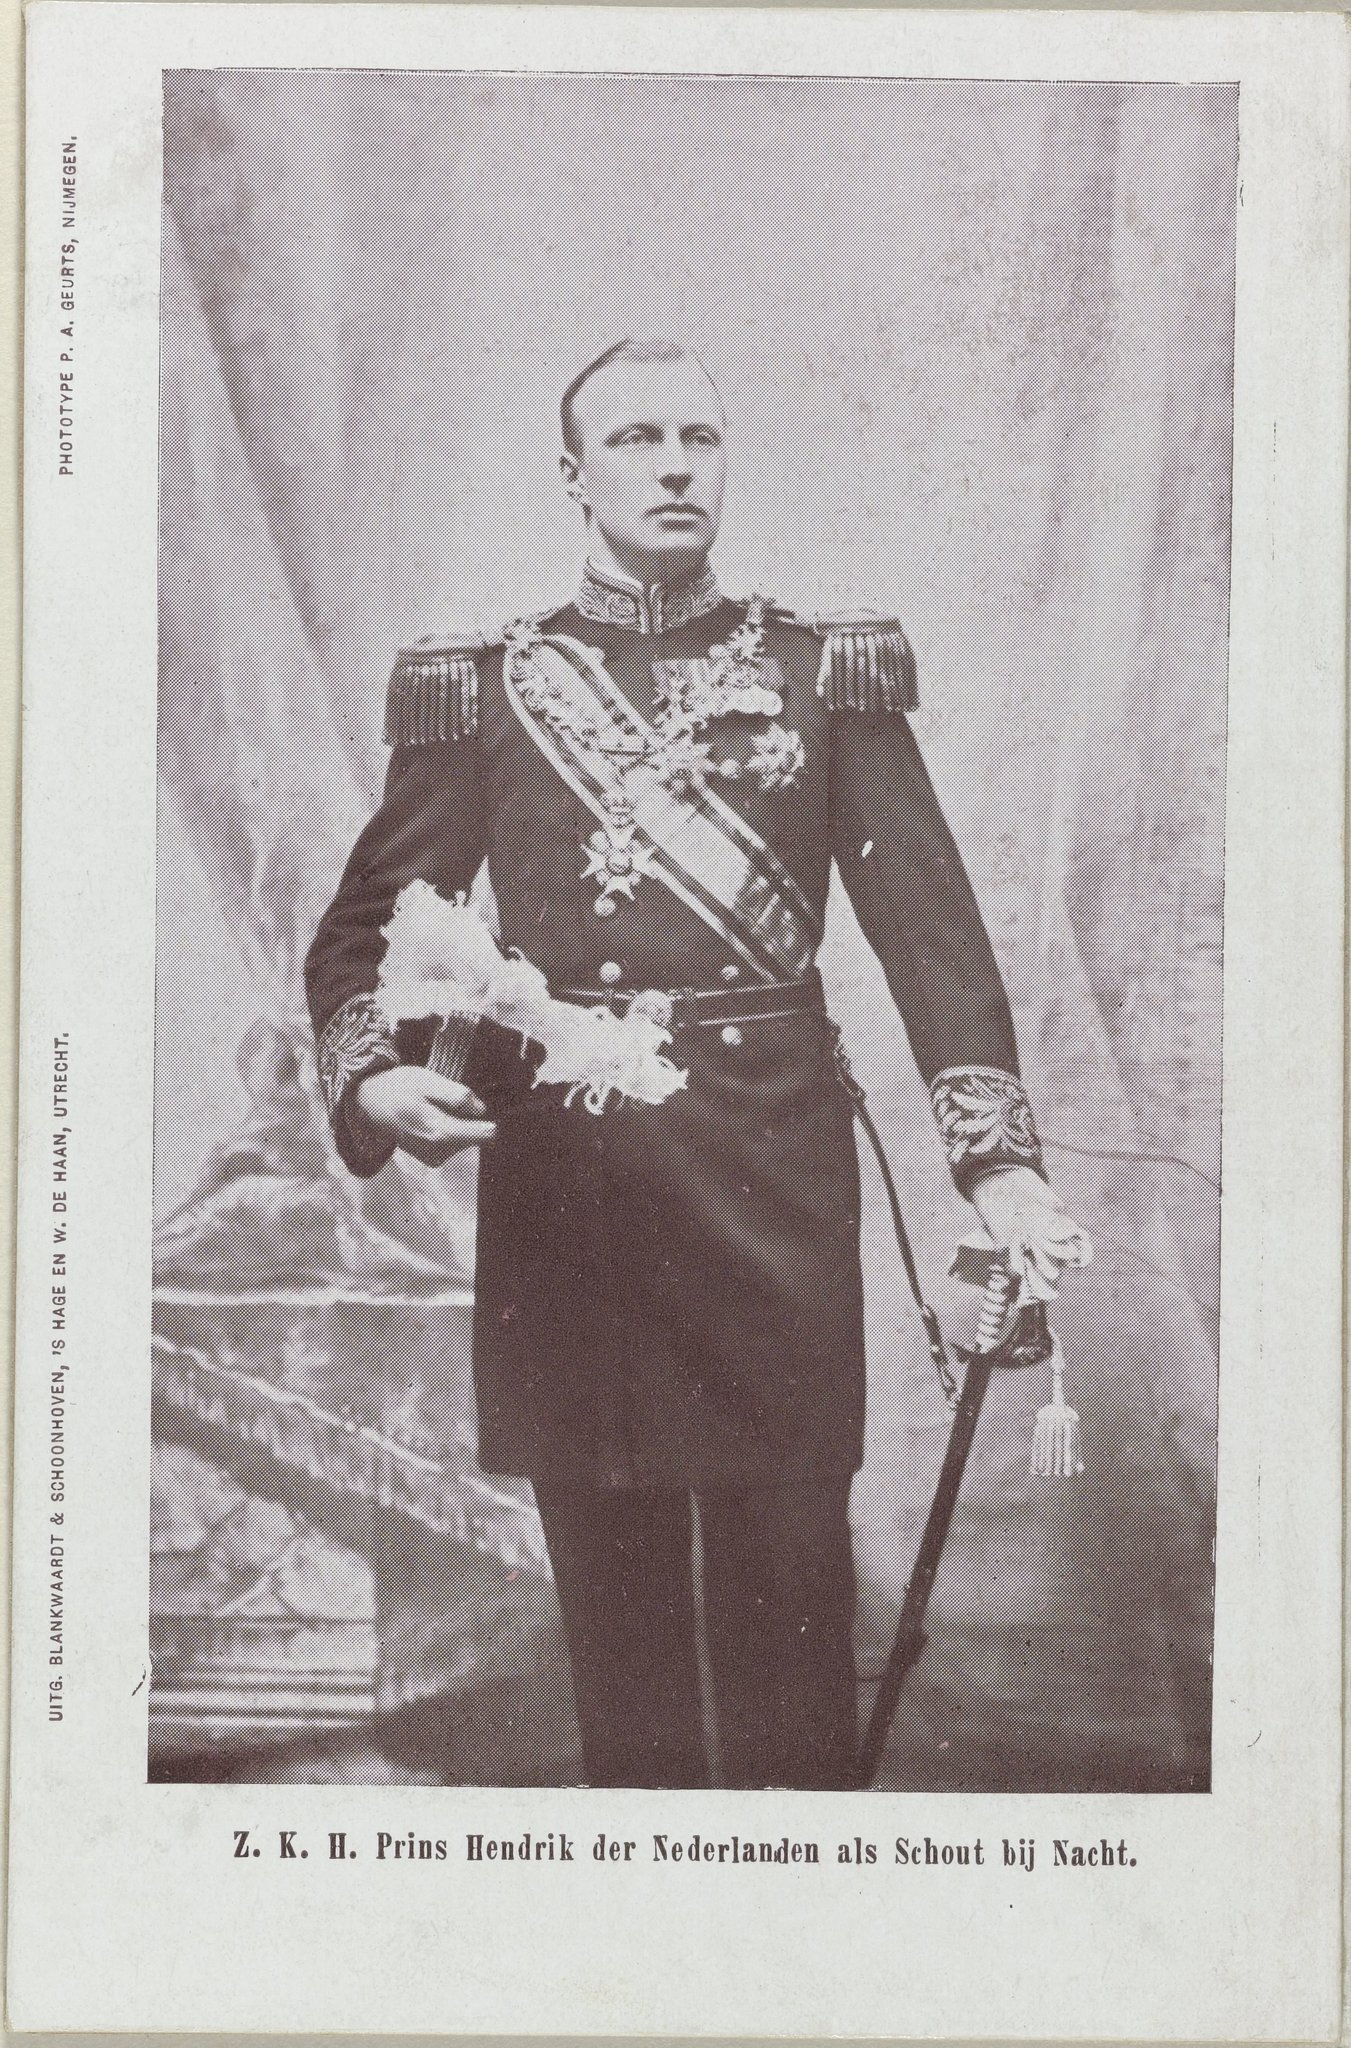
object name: photomechanical print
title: Portret van Hendrik van Mecklenburg-Schwerin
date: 1900-1910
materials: paper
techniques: autotype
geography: the hague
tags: the hague, hendrik (prins der nederlanden (1876-1934))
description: Portret van Hendrik. In de ondermarge een regel Nederlandse tekst.